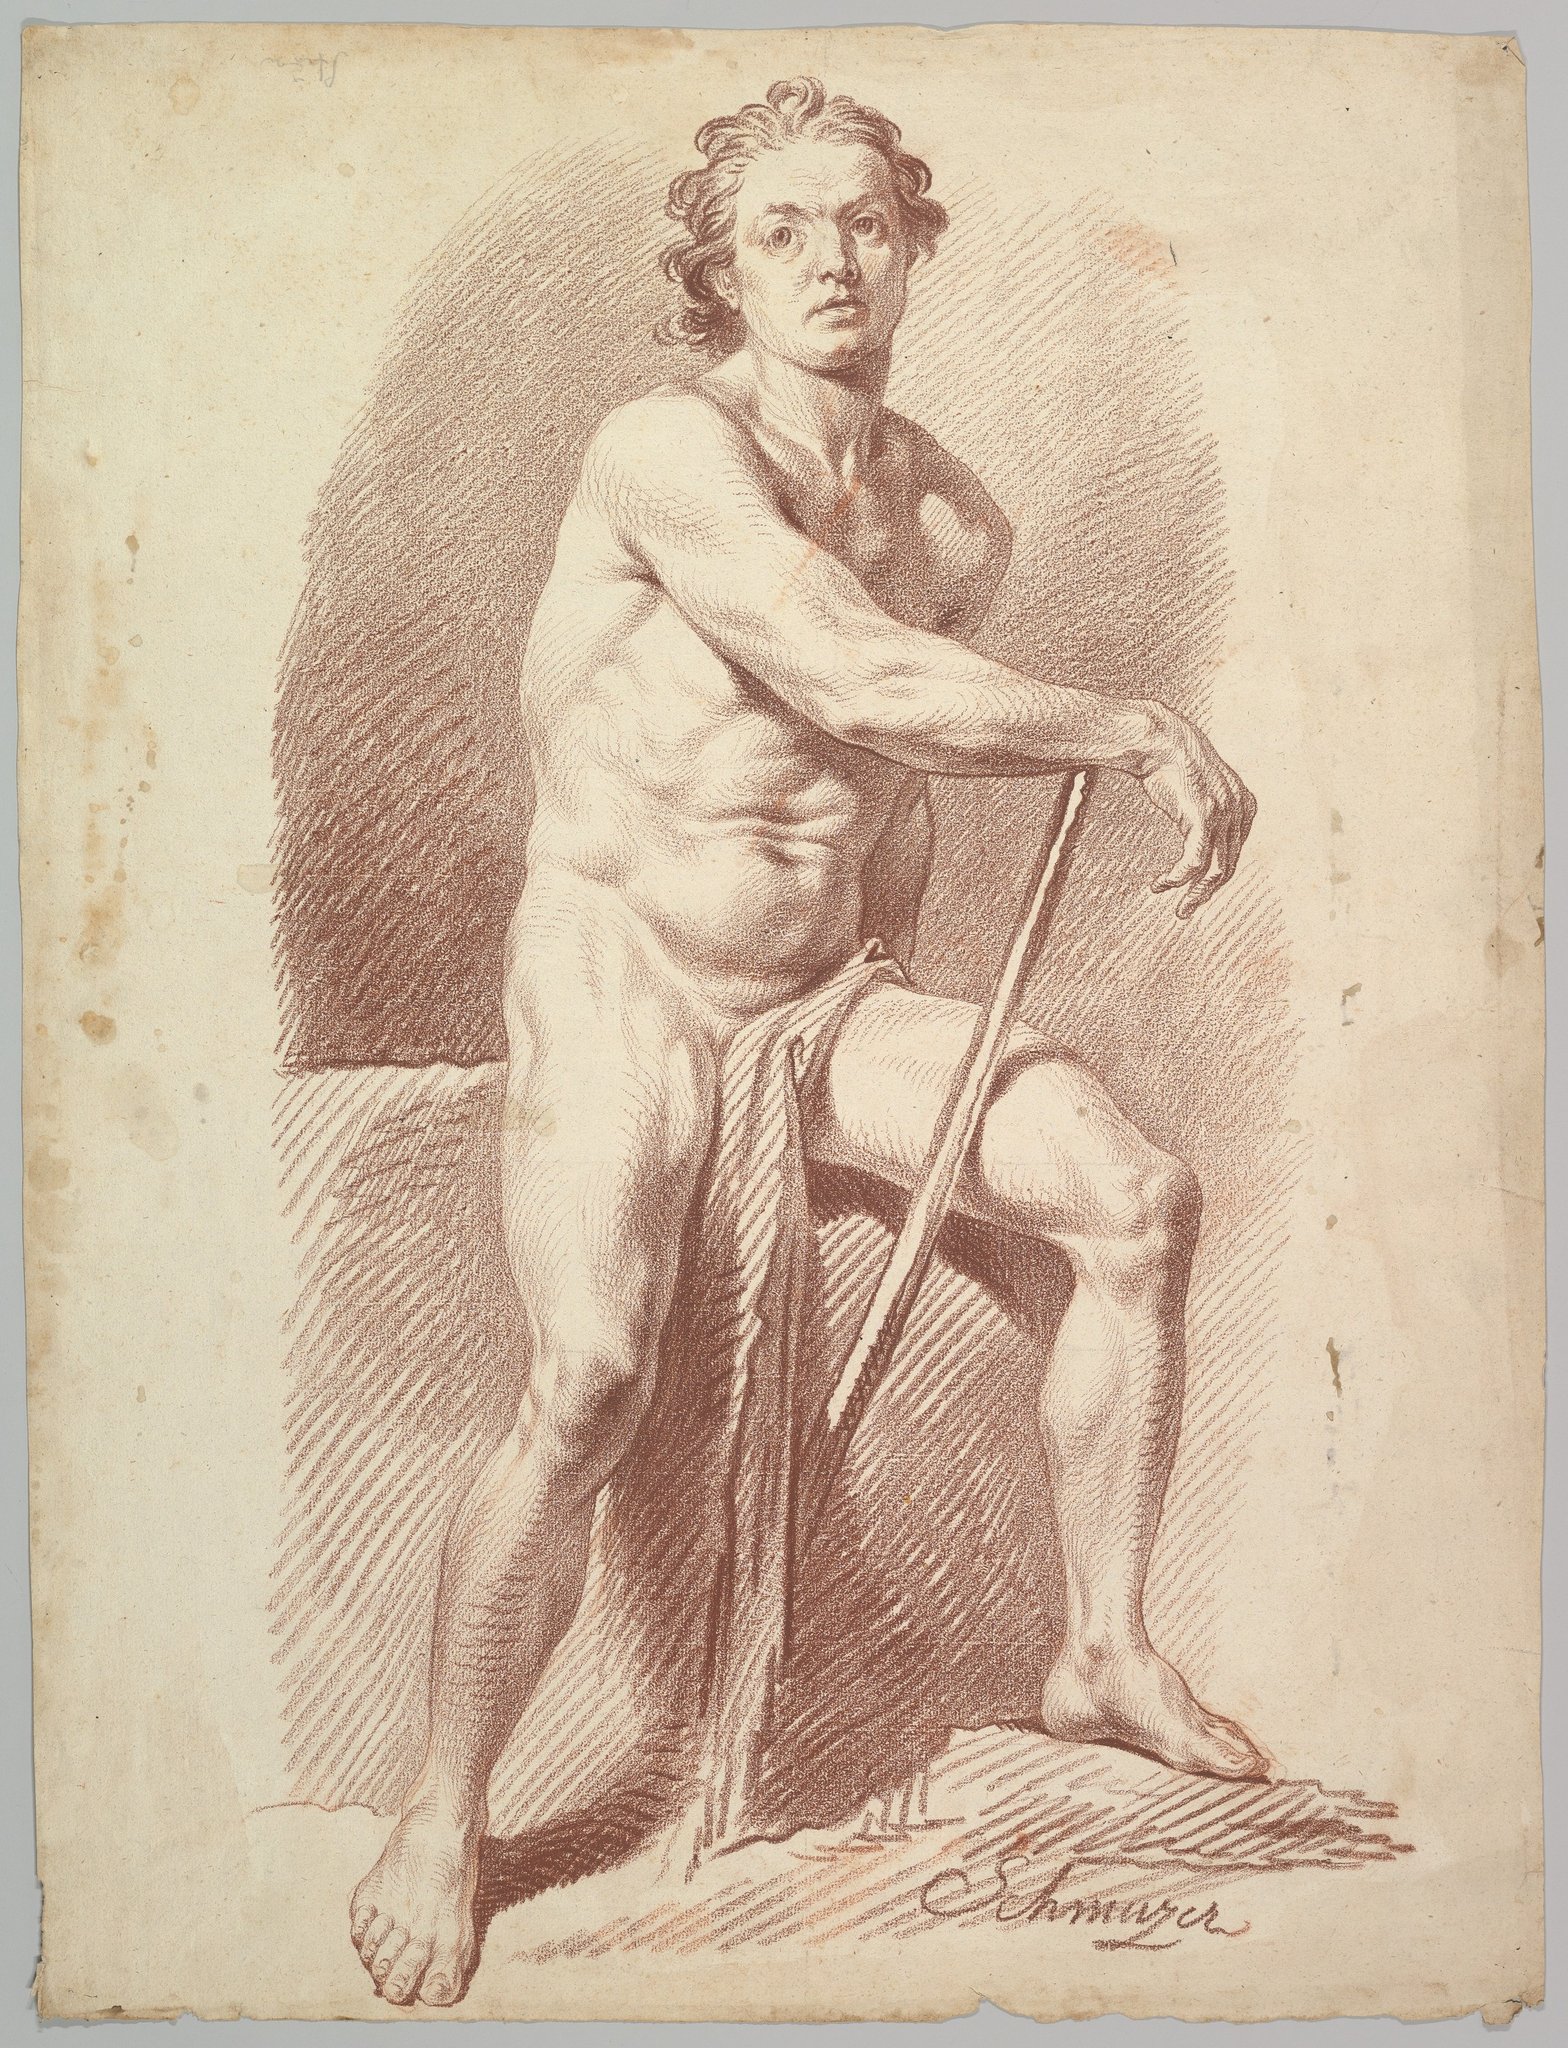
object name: drawing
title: Seated Male Nude Resting on a Stick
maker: jakob matthias schmutzer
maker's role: artist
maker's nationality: austrian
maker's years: 1733-1811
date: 1765-1810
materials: chalk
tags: male nudes